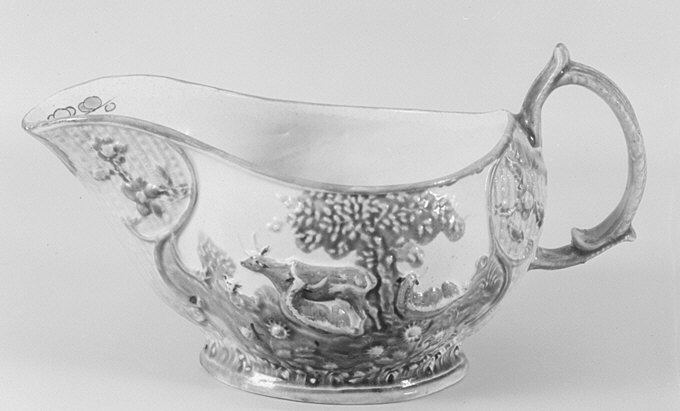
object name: sauceboat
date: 1760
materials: stoneware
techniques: salt glaze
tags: animals,trees